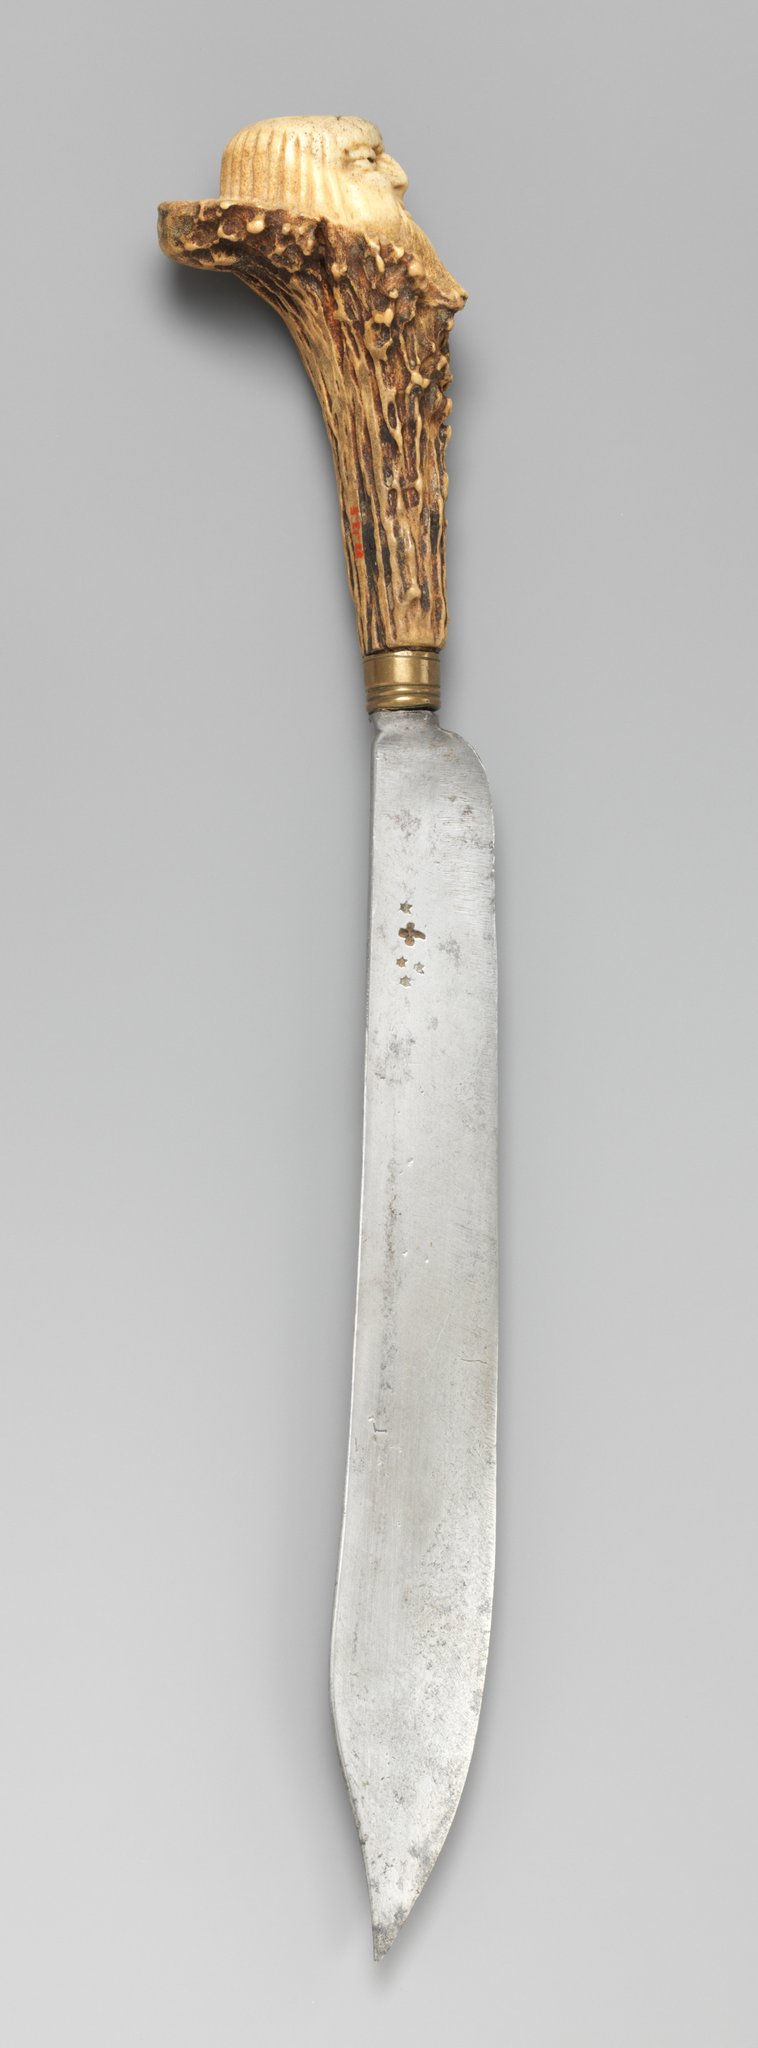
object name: knife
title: Carving knife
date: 1801-1900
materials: steel